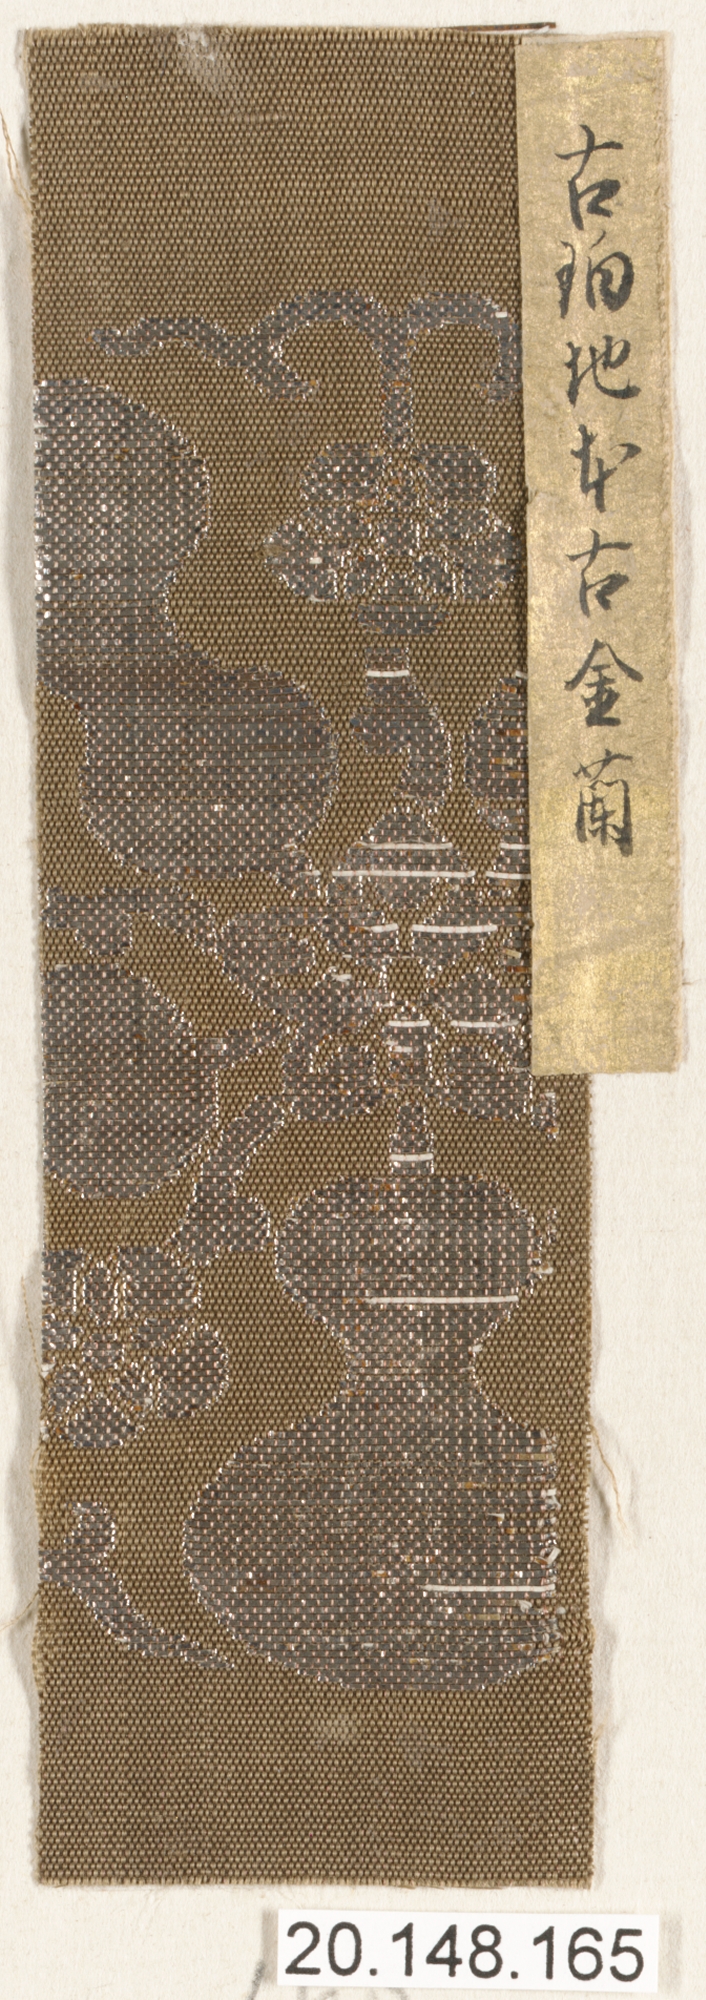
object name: piece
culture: japanese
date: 1601-1700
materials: silk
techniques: compound weave